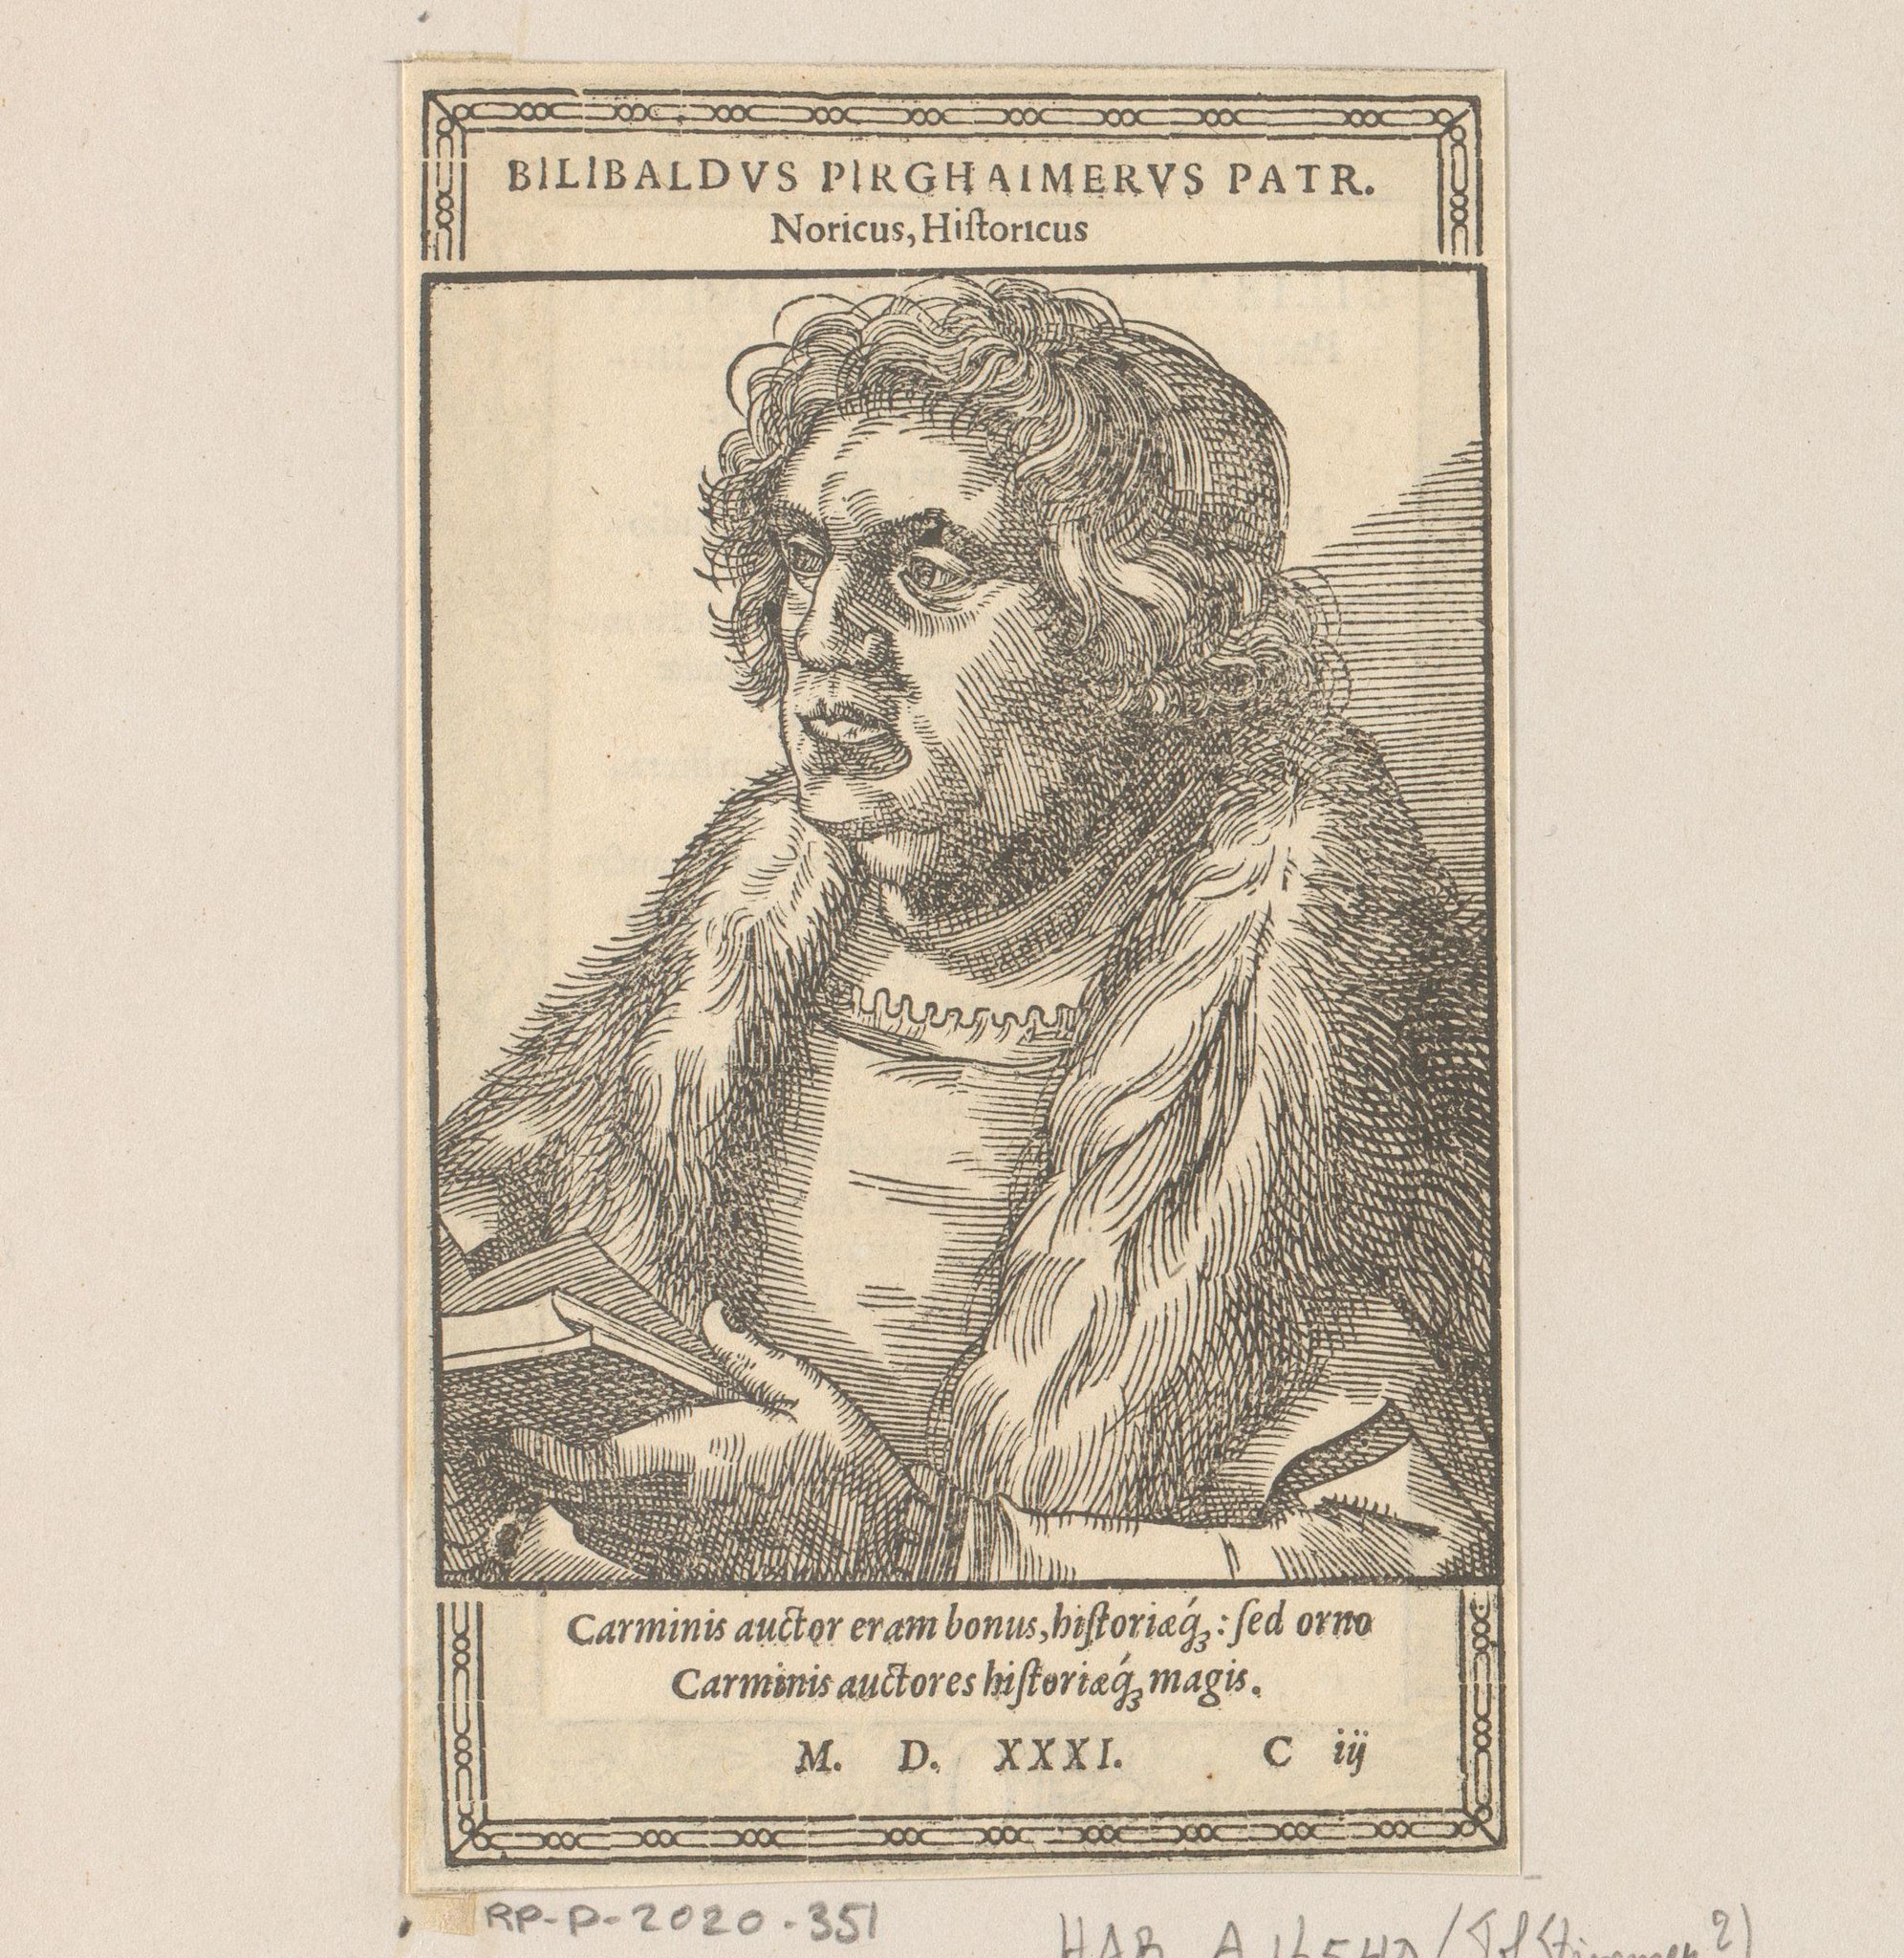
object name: print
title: Portret van Willibald Pirckheimer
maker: bernhard jobin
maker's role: printer, publisher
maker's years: 1545-1593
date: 1587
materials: paper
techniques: letterpress printing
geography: straatsburg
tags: eichstätt, willibald pirckheimer, historical persons, portrait of a writer, book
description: Prent uit: Reusner, Nikolaus. Icones sive imagines virorum literis illustrium (...). Straatsburg: Bernhard Jobin, 1587. Prent ook gebruikt in de Duitse editie, uitgegeven in hetzelfde jaar, en de 1590-editie. Prent ook gebruikt in latere publicaties.